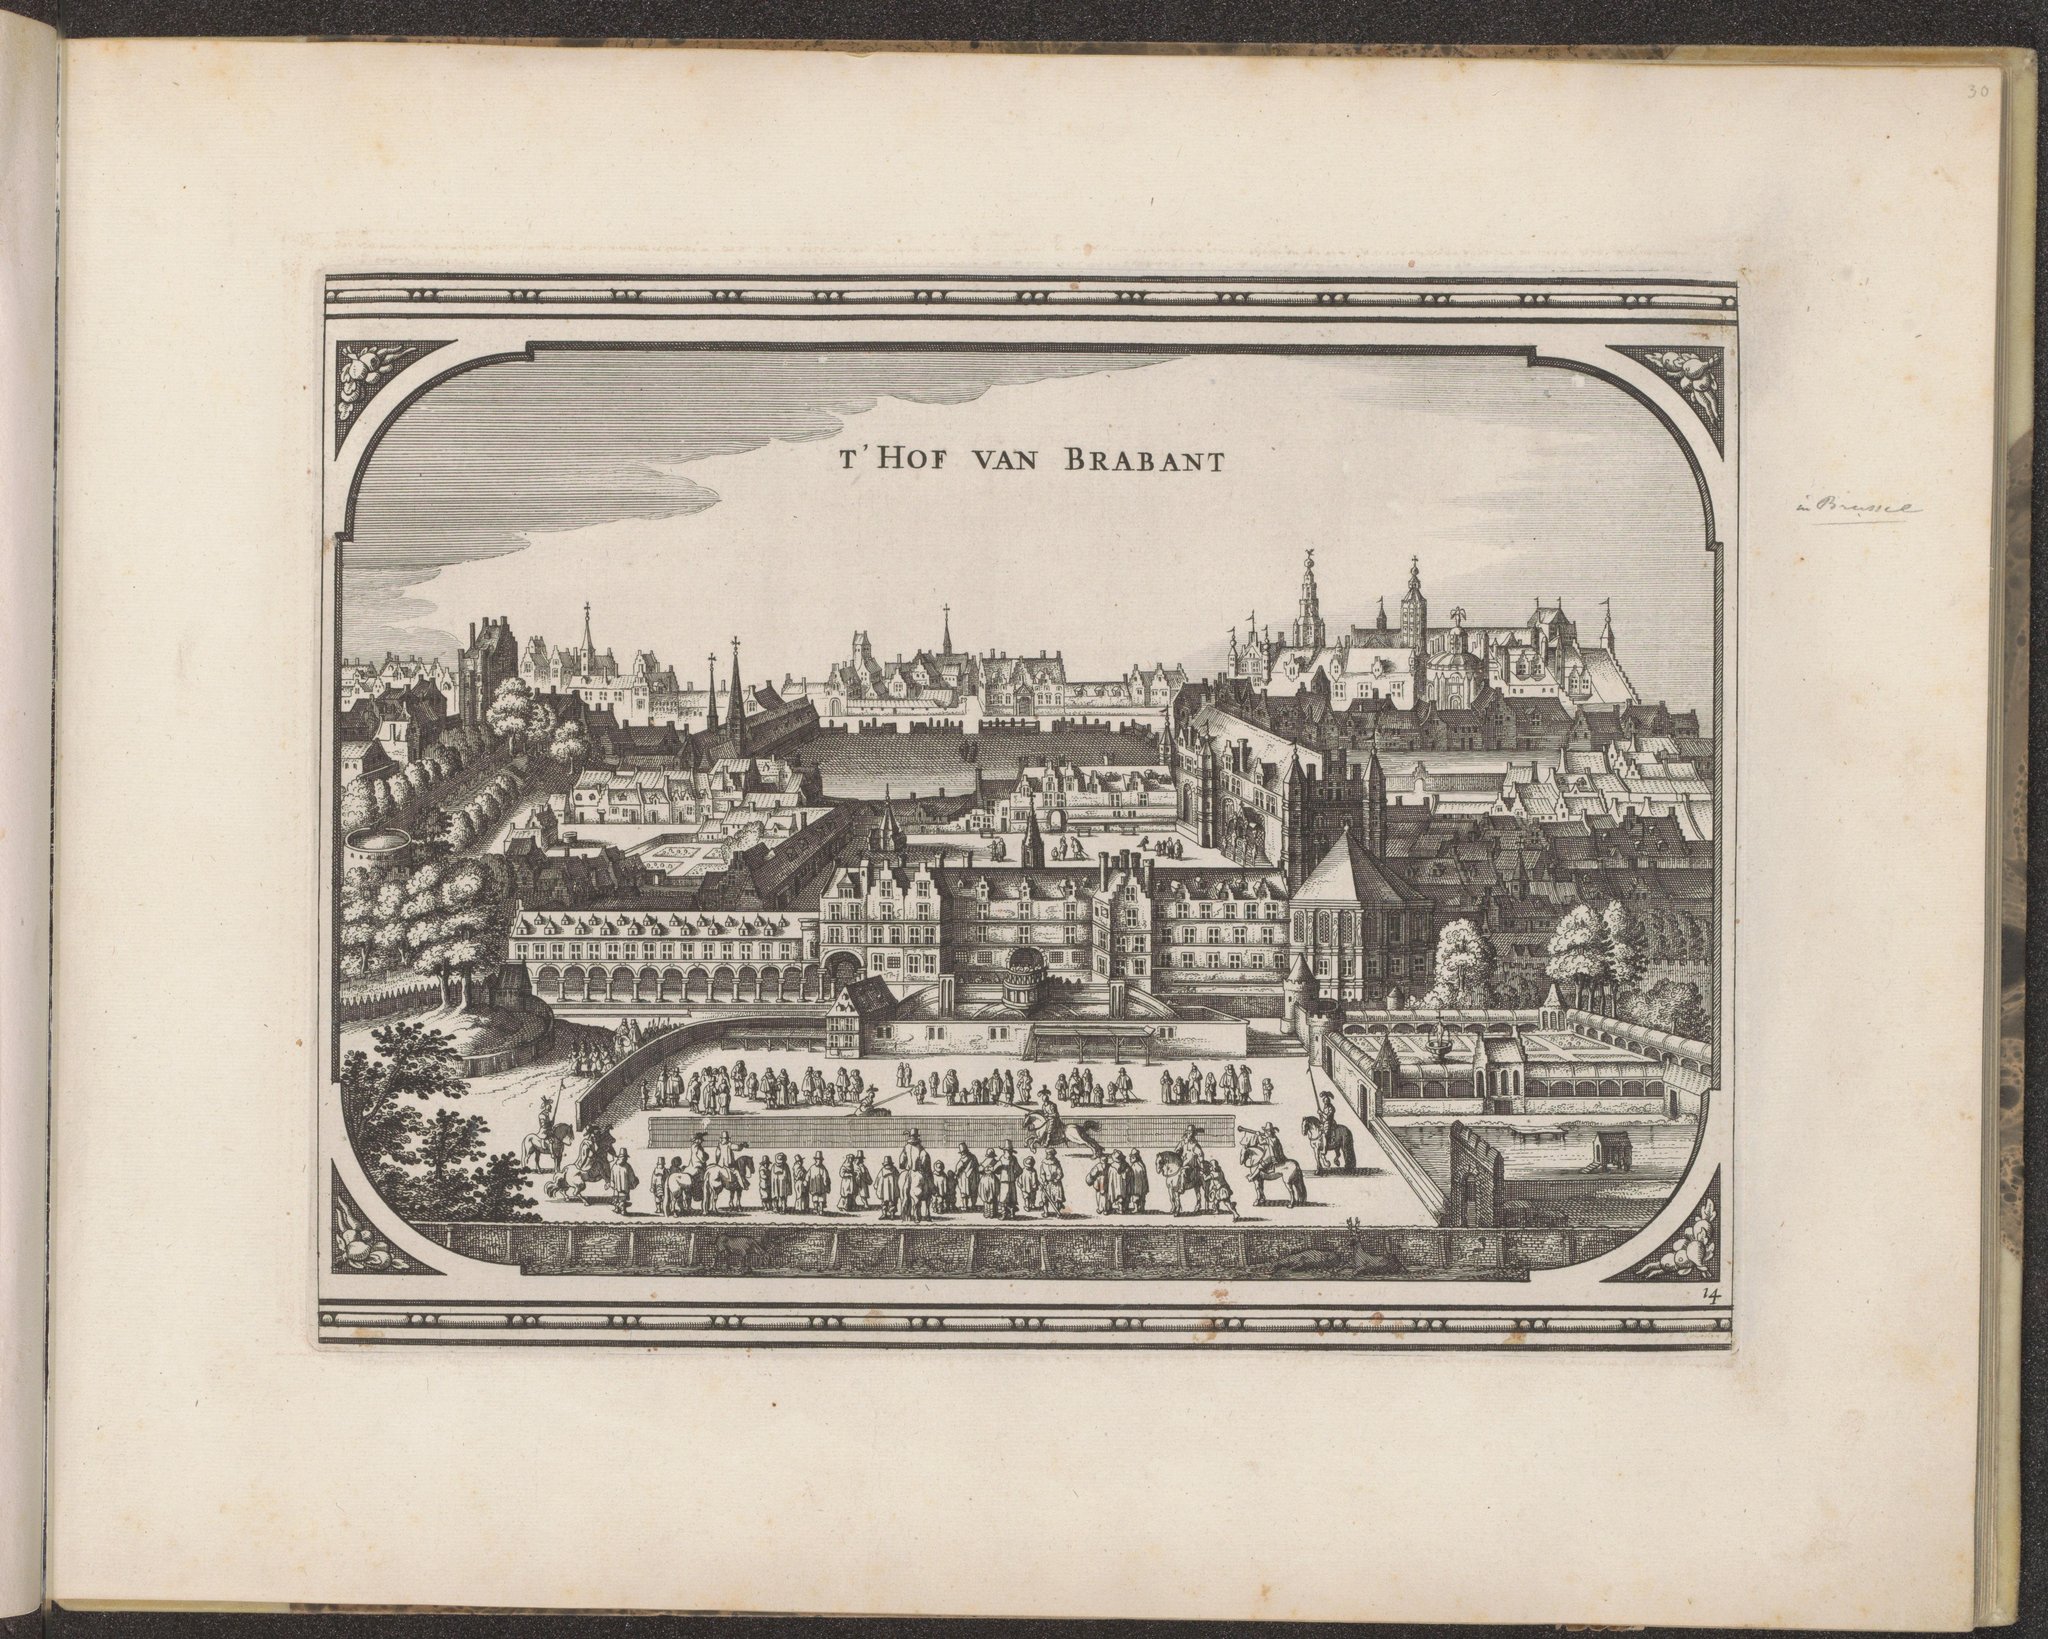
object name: album leaf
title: Binnenplaats van het Paleis op de Koudenberg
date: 1660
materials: paper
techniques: etching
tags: city-view in general; 'veduta', tournament, joust, tilt, brussels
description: Het hof van Brussel, oftewel het Paleis op de Koudenberg. Op de voorgrond 'Die Warande' met twee herten, daarachter een steekspel met ridders. De prent maakt deel uit van een album.